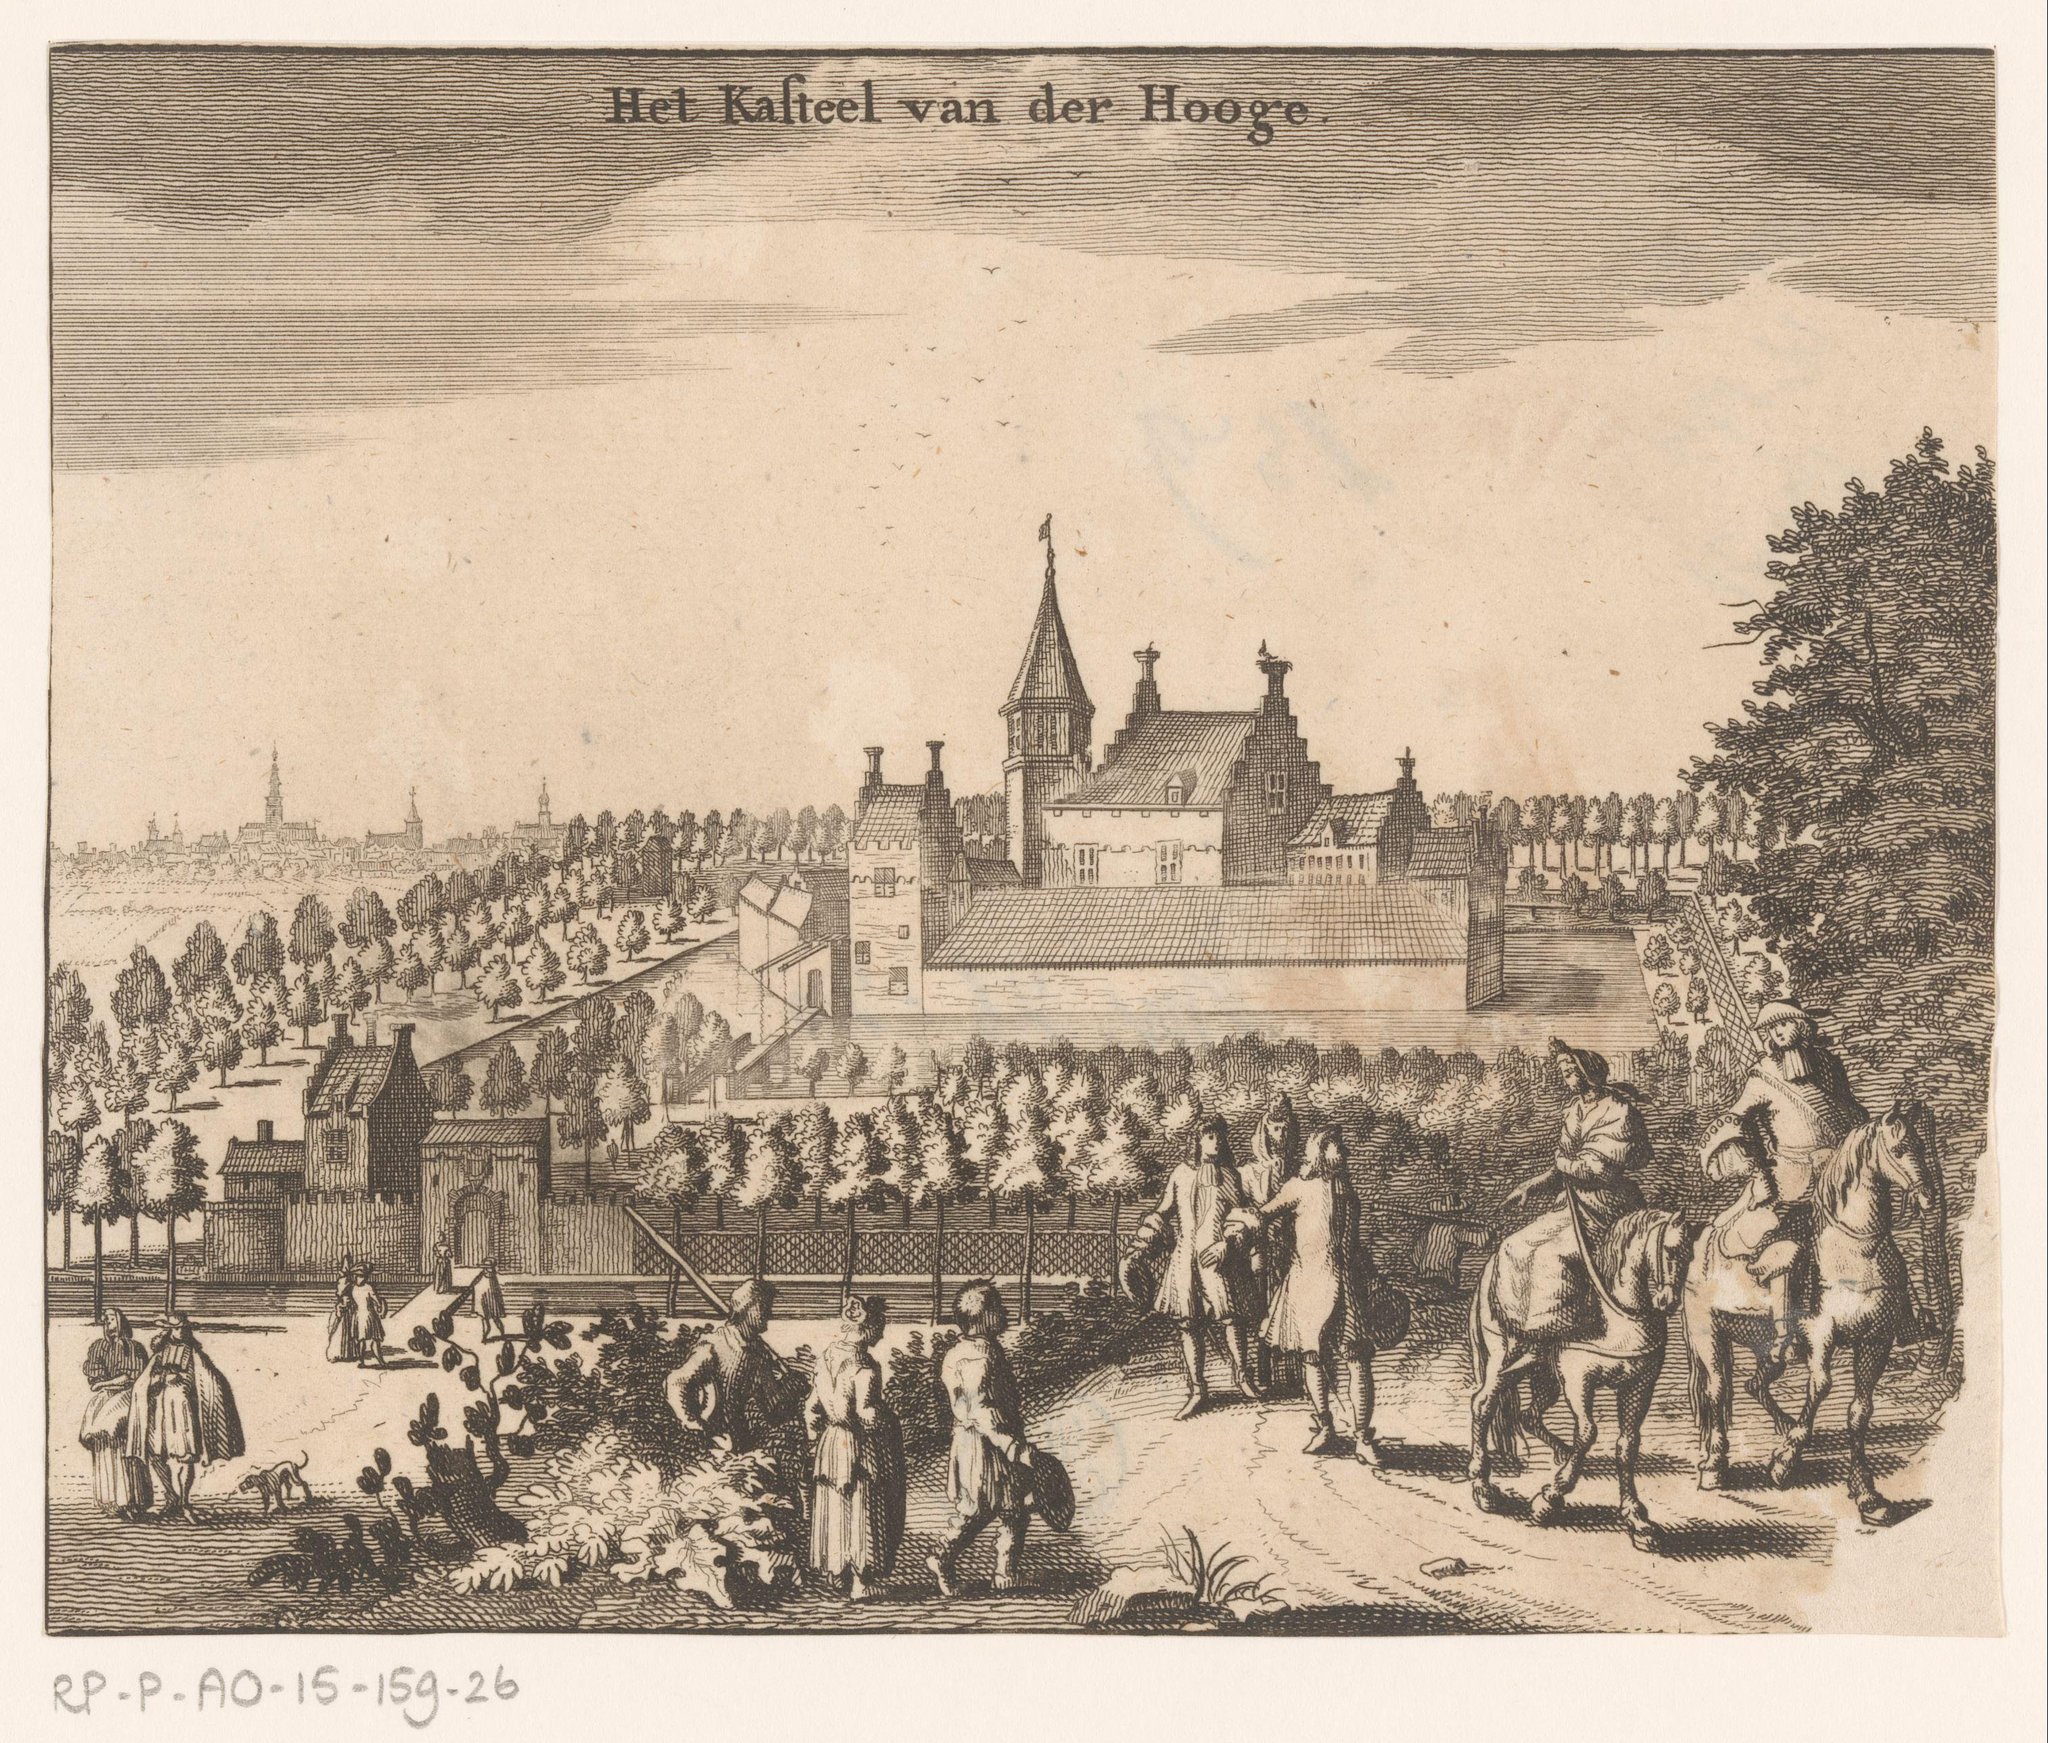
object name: print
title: Het Kasteel van der Hooge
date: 1696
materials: paper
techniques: engraving, etching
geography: middelburg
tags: castle, prospect of city, town panorama, silhouette of city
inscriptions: collector's mark: Lugt 195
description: Oorspronkelijk van één plaat gedrukt met drie andere voorstellingen (zie RP-P-AO-15-154 en RP-P-AO-15-159-1). Prent in zijn geheel ook gebruikt in: Smallegange, Mattheus. Nieuwe Cronyk van Zeeland (…). Middelburg en Amsterdam: Johannes Meertens en Abraham van Someren, 1696. Huidige voorstelling later (plaat mogelijk versneden) met twee andere voorstellingen van andere plaat en apart gedrukte sierrand ook gebruikt in: Aa, Pieter van der. La galerie agreable du monde (...). 66 delen. Leiden: Pieter van der Aa, 1728, dl. 20.